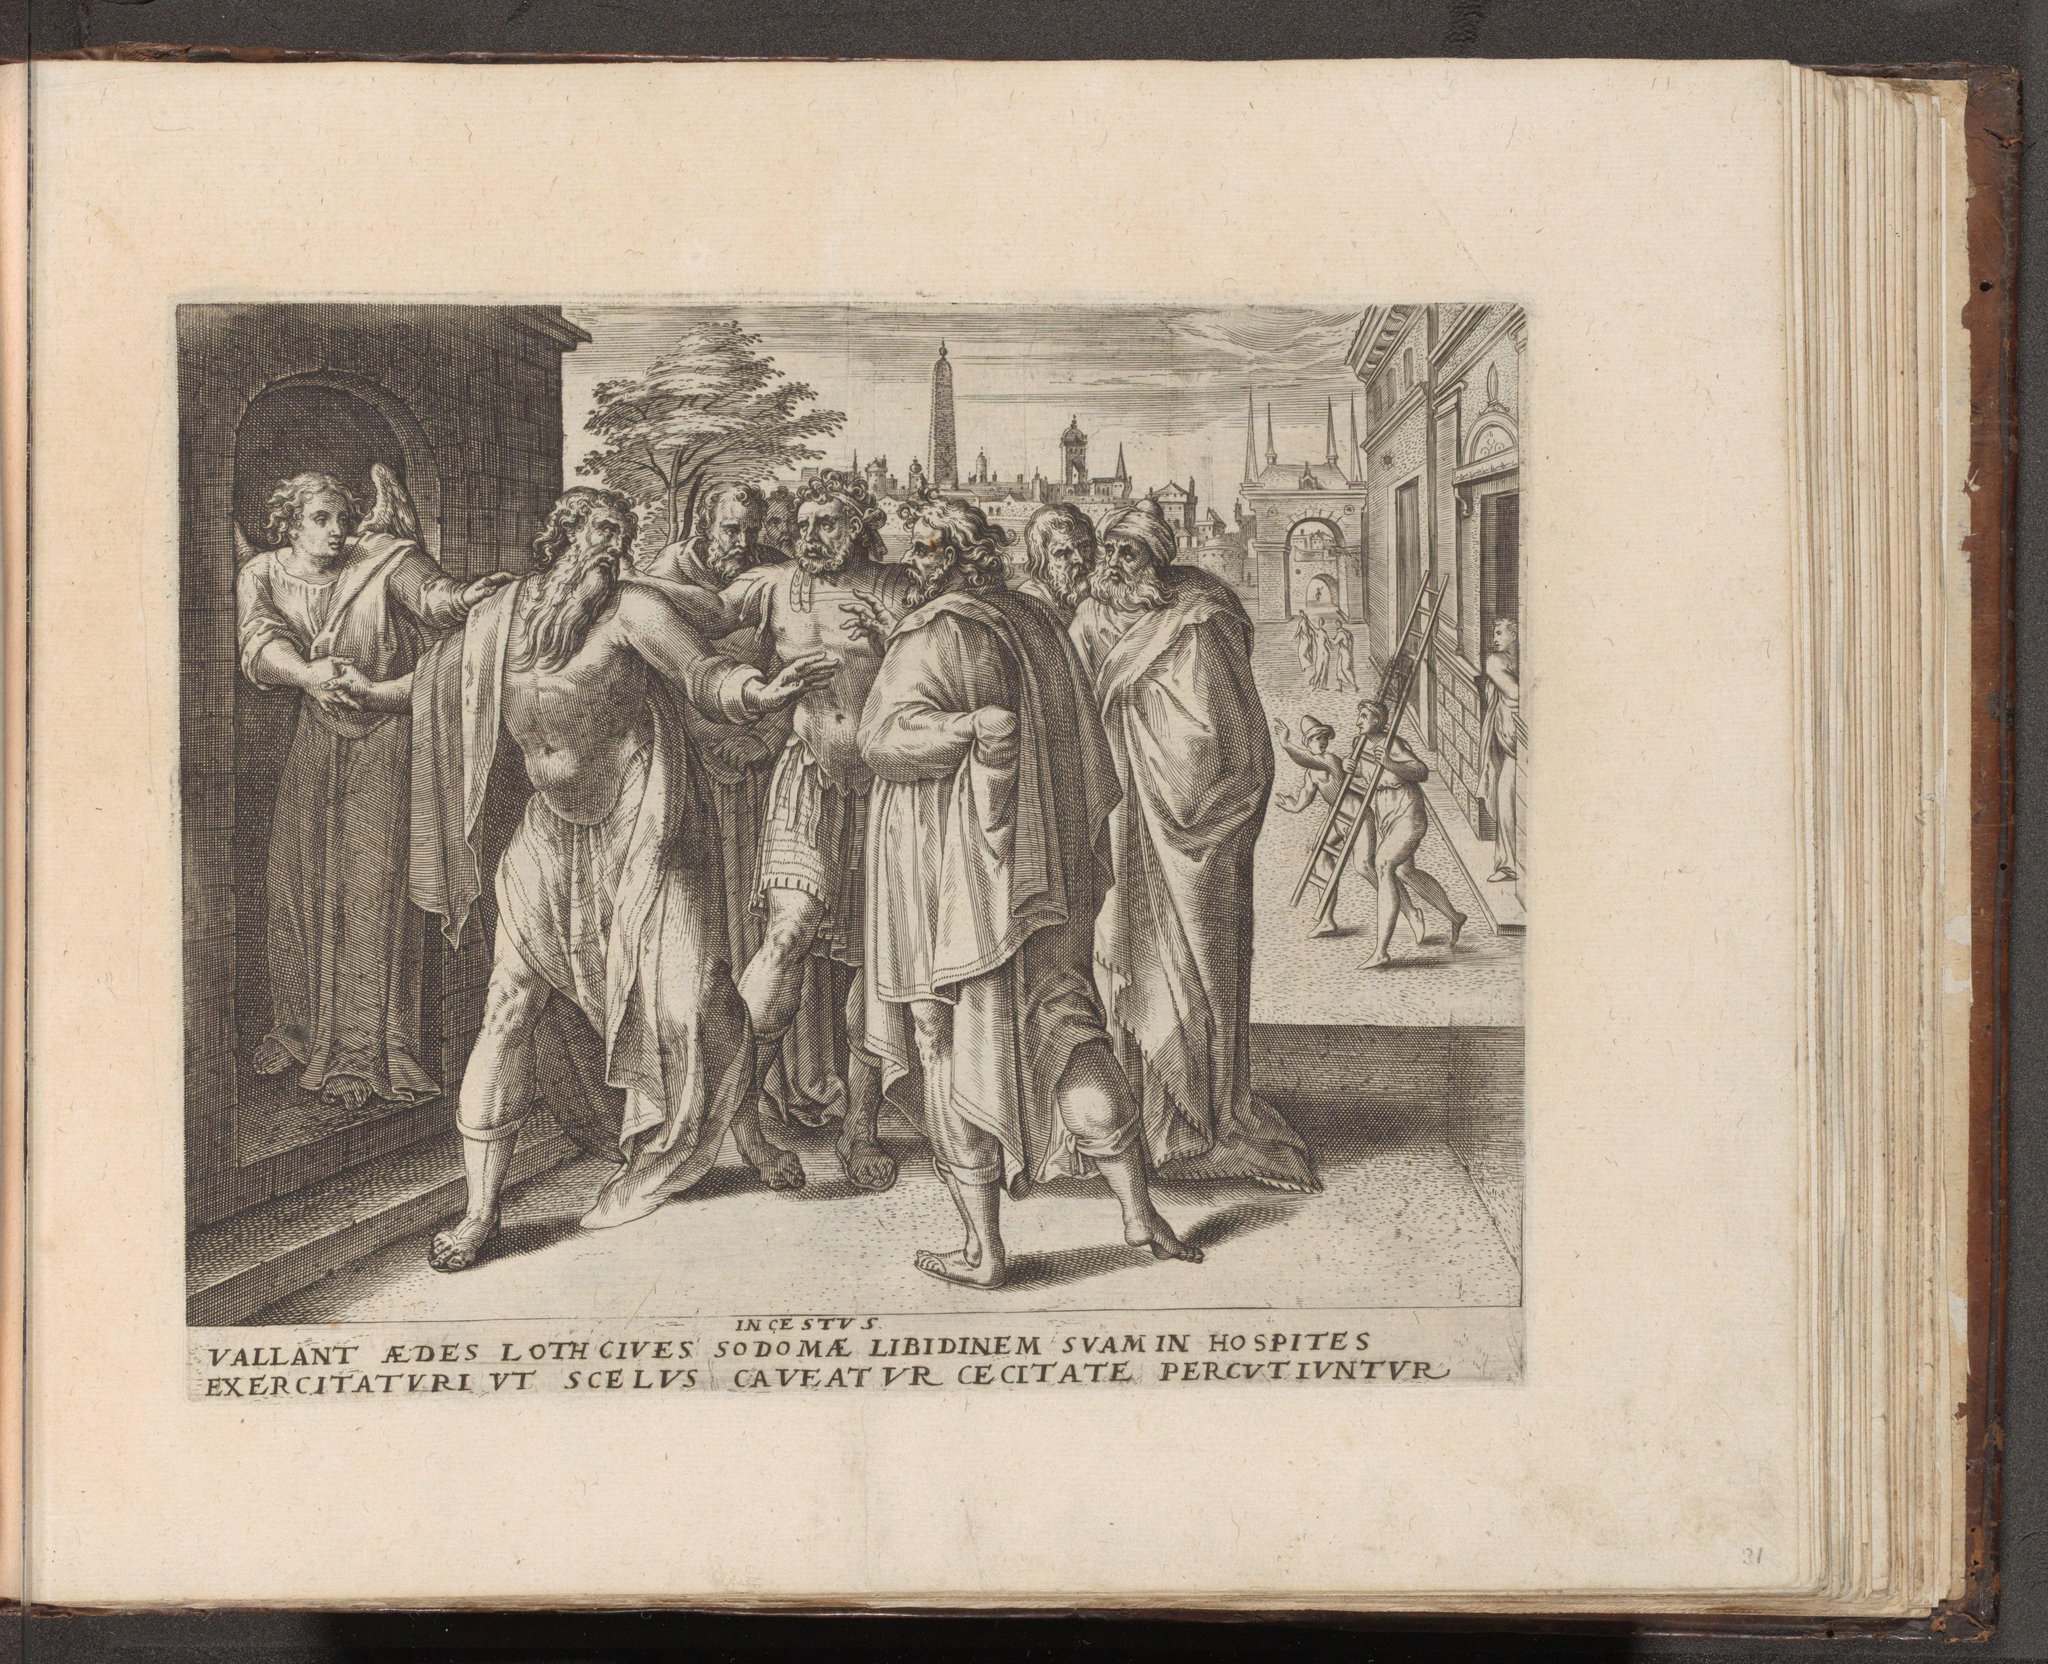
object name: print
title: Lot maant de menigte tot kalmte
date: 1579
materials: paper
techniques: engraving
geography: antwerp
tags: lot tries to pacify the mob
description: Dit is de eerste staat van drie van de tweede editie van deze prent. De eerste editie werd mogelijk door Hieronymus Cock uitgegeven. De plaat kwam, vermoedelijk na de dood van Cock, in handen van Gerard de Jode. De voorstelling van de plaat werd toen compleet verwijderd en er kwam een iets andere compositie voor in de plaats. Alleen de tekst bleef ongewijzigd.